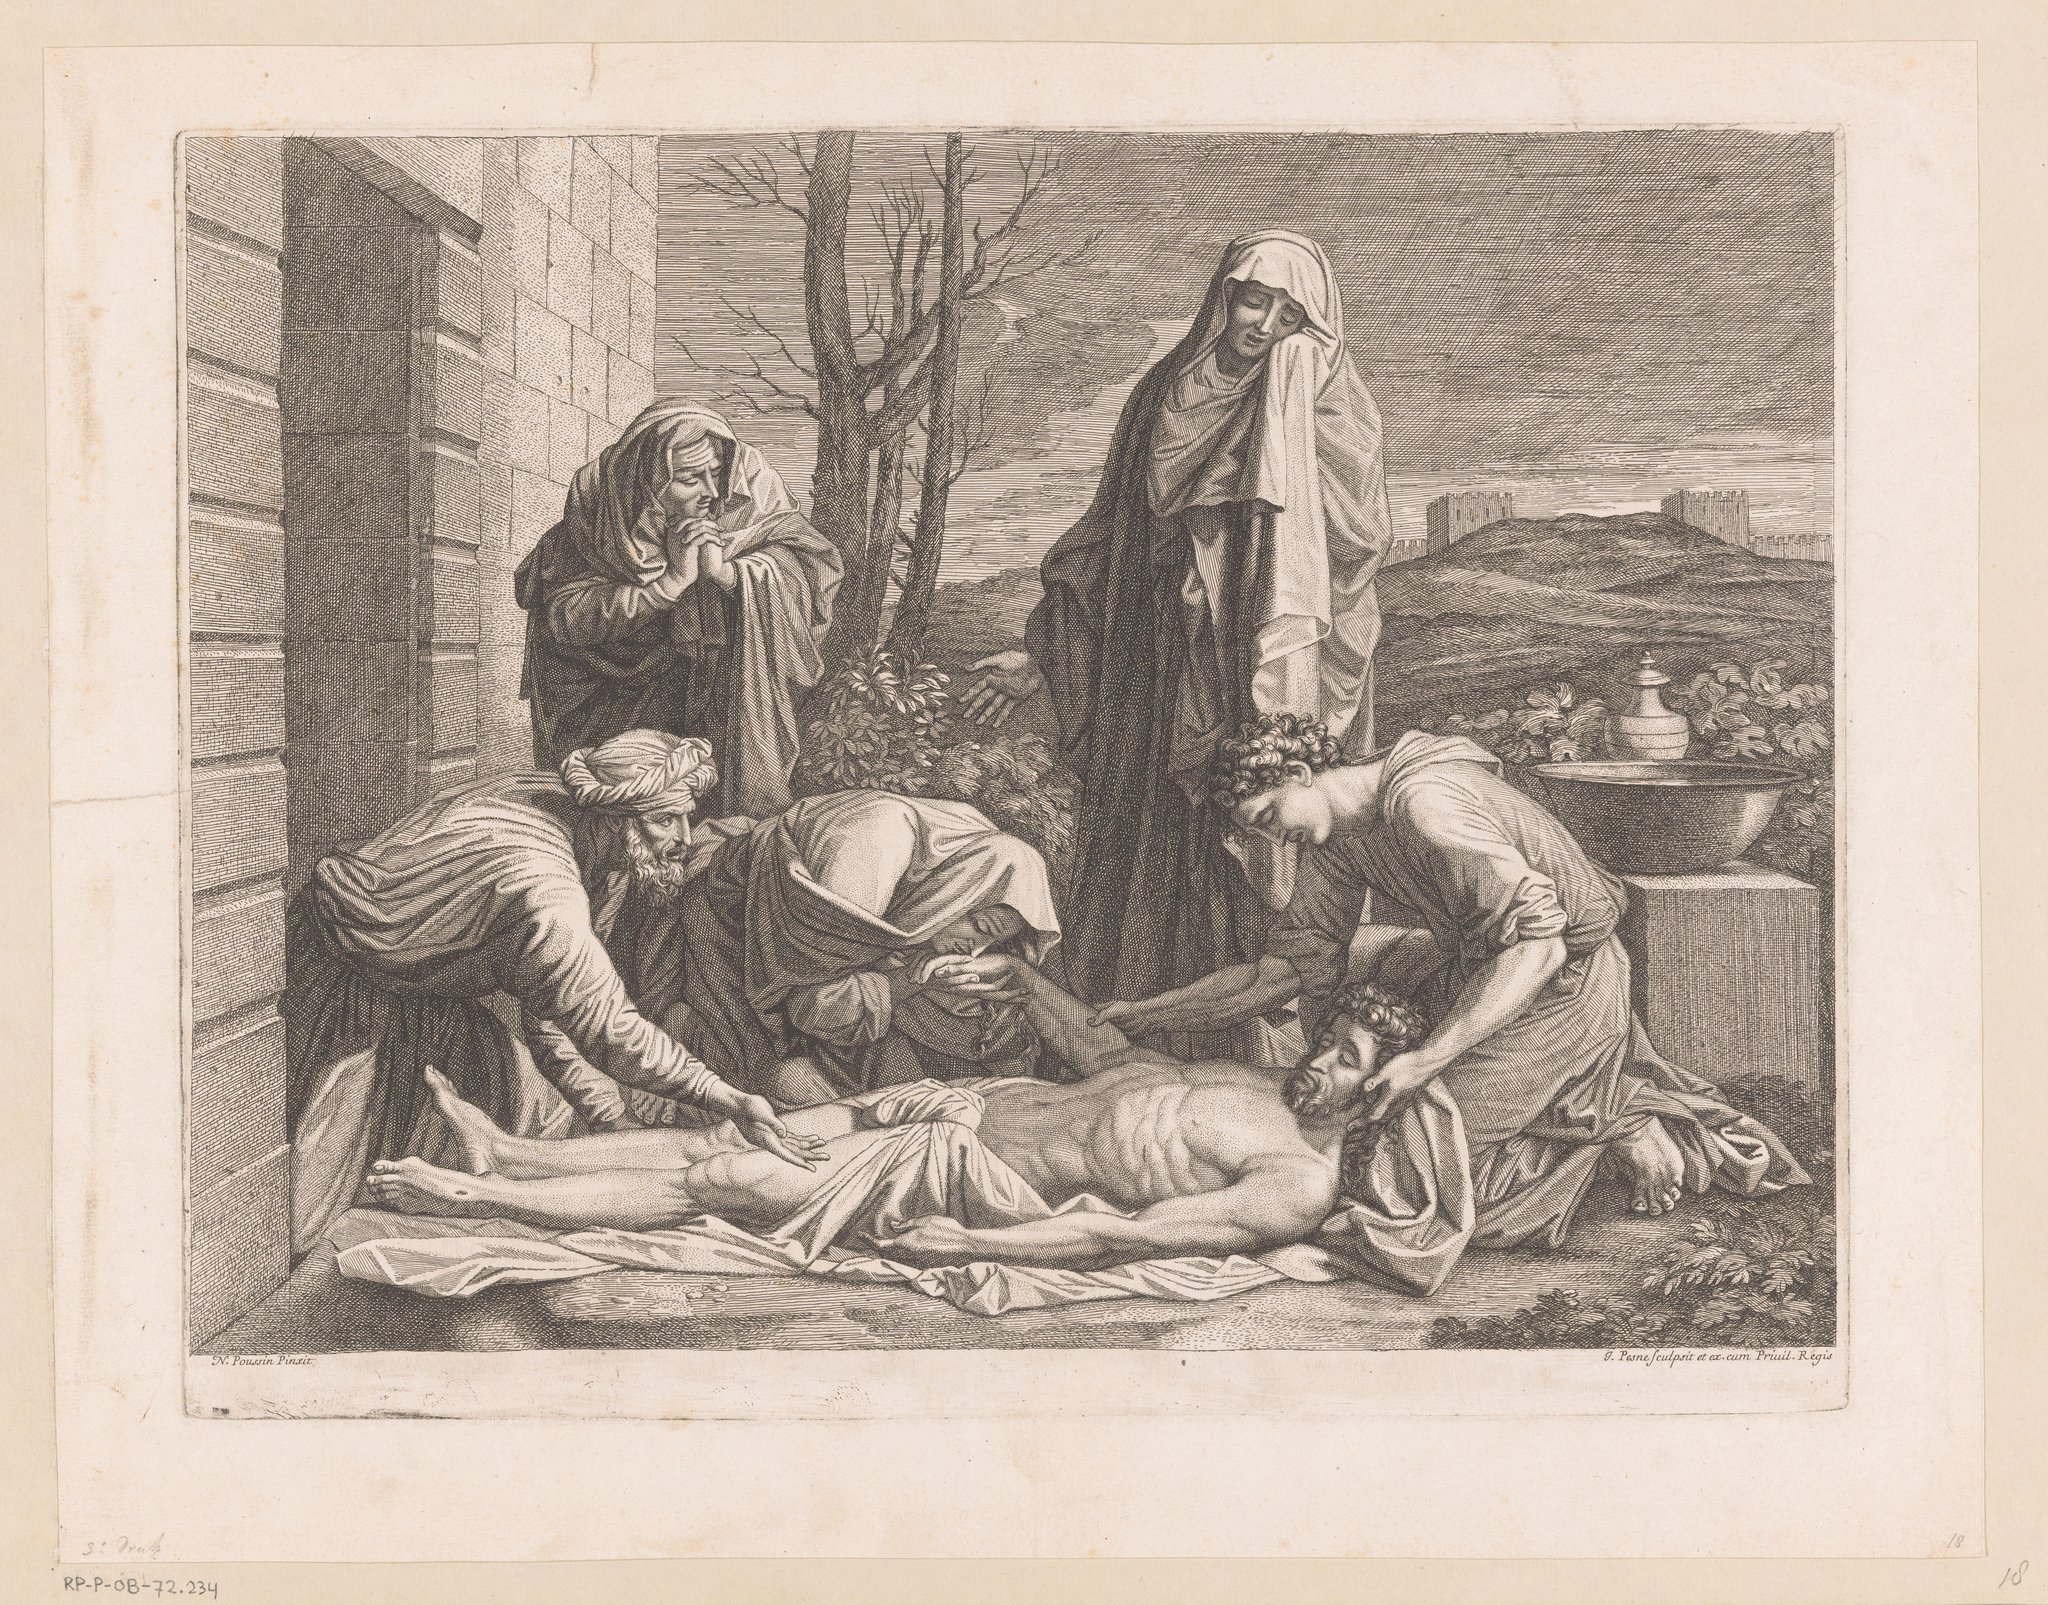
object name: print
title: Bewening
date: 1640-1700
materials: paper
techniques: engraving, etching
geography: france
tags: the mourning over the dead christ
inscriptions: collector's mark: Lugt 240